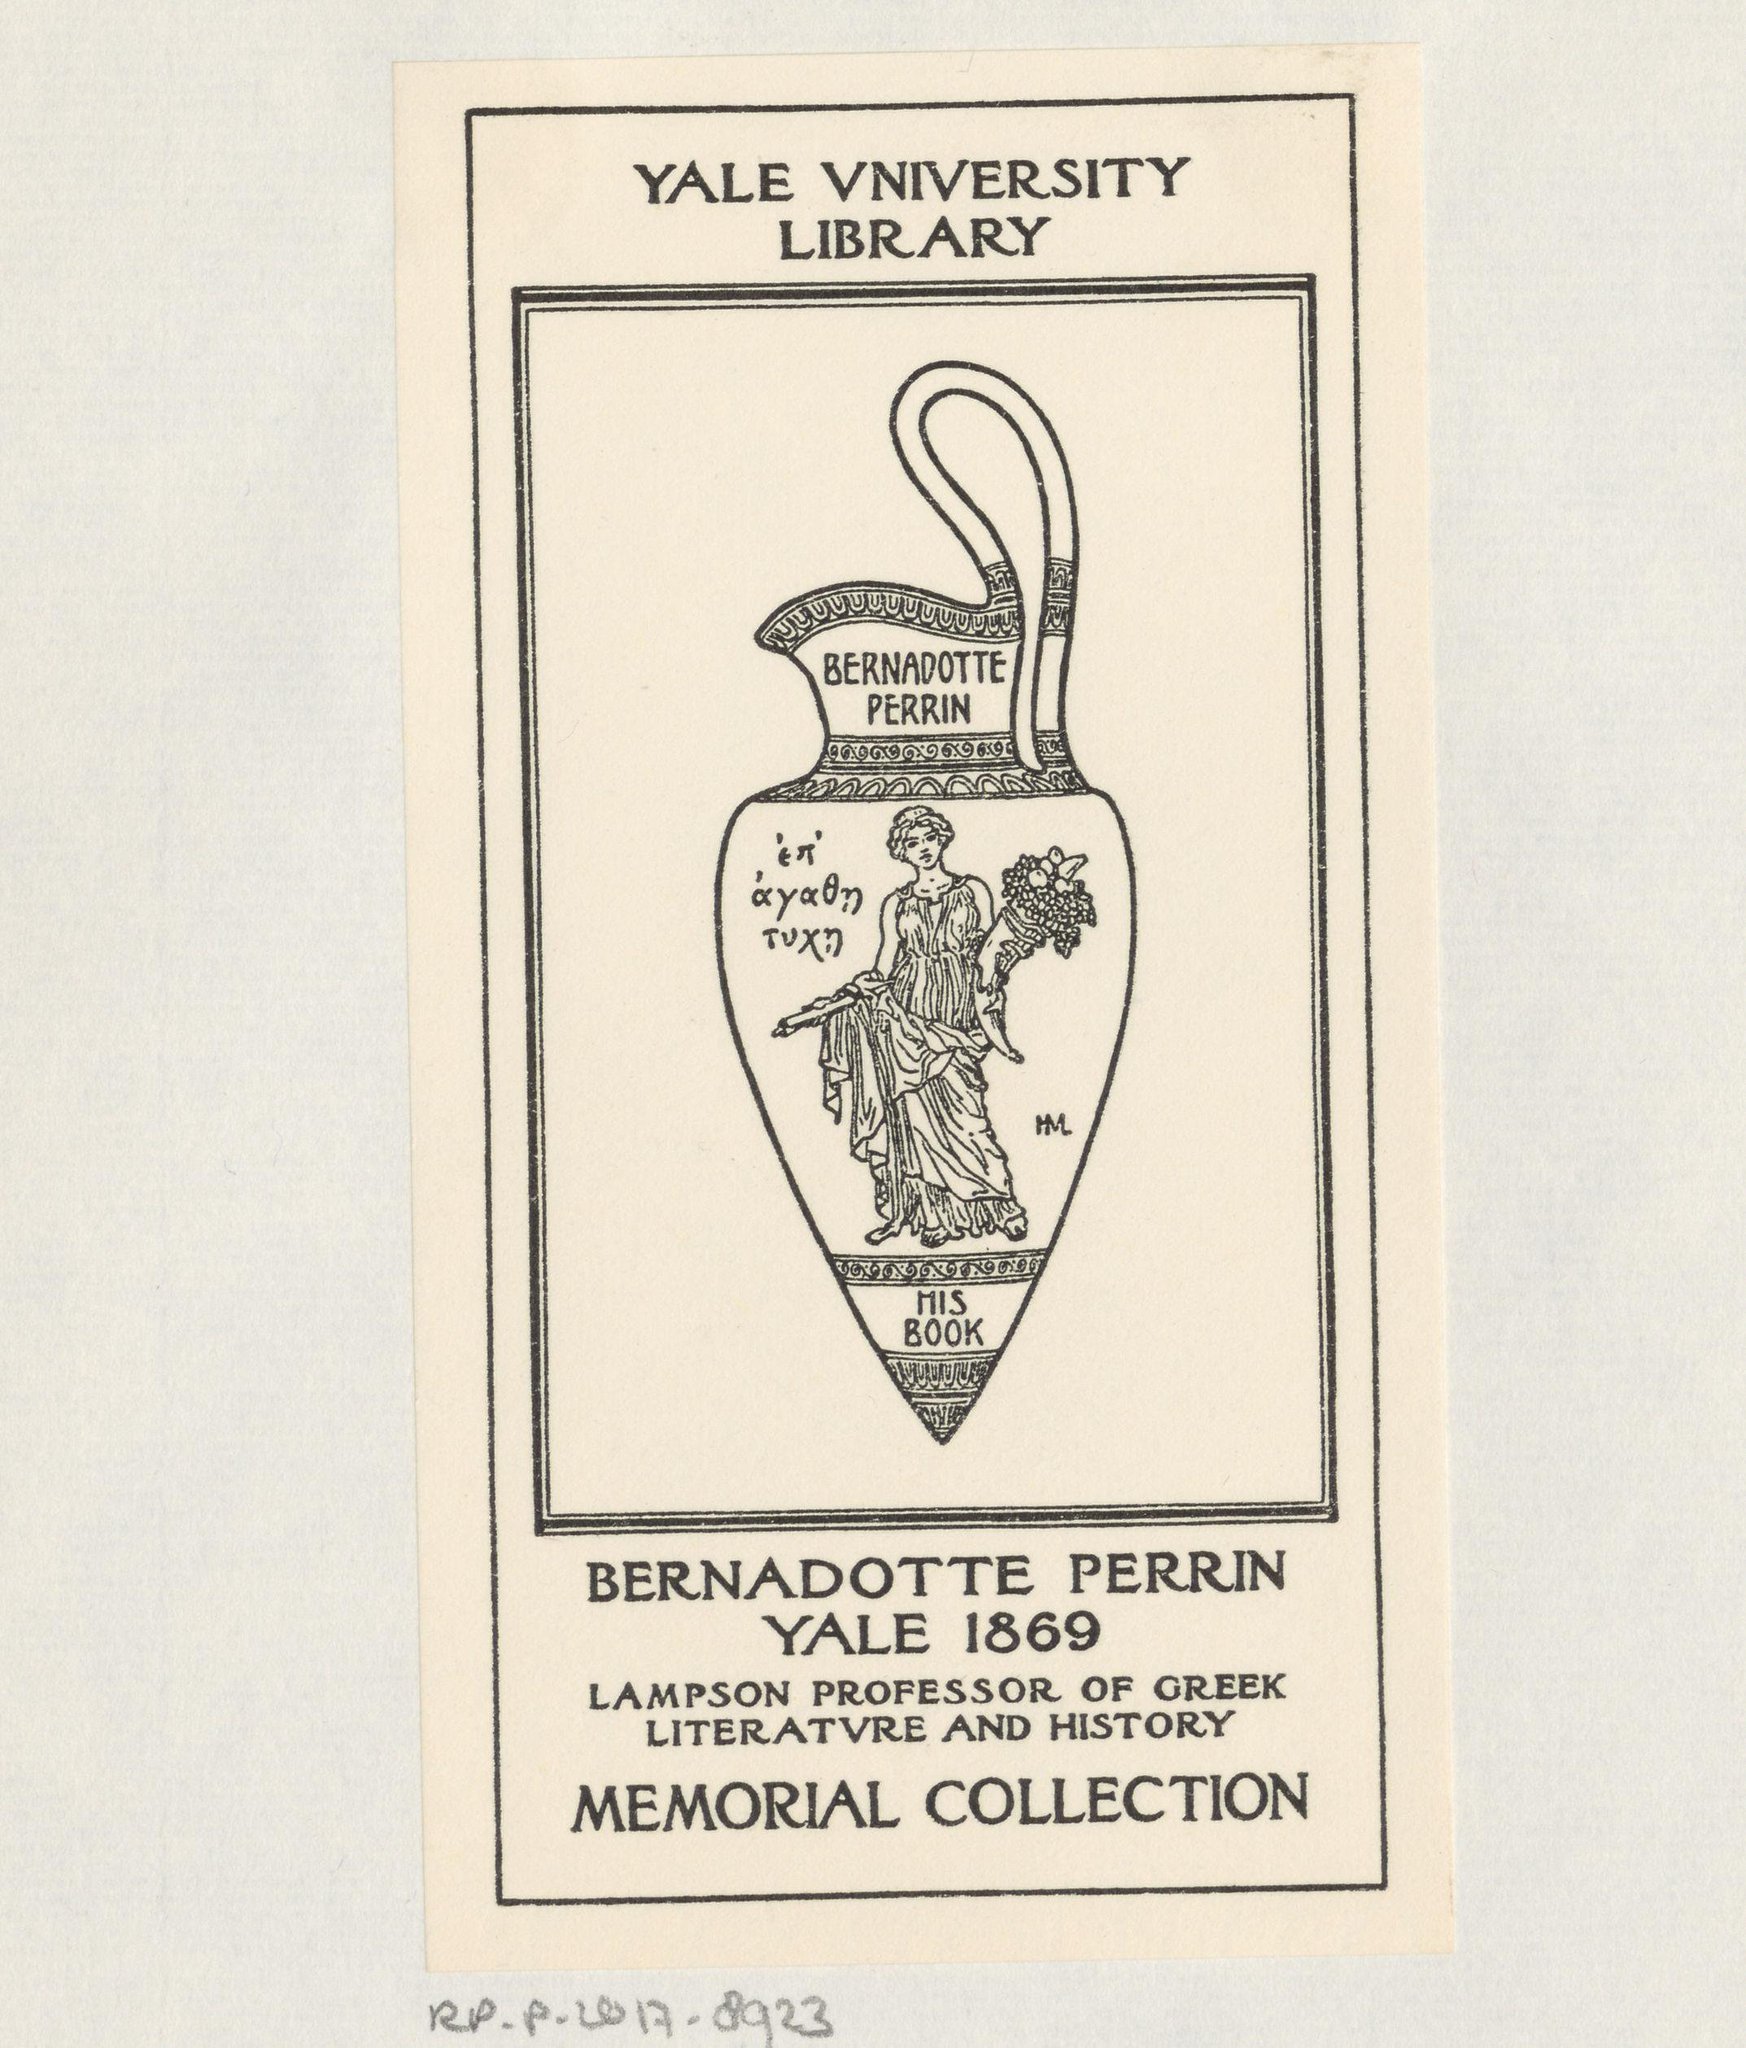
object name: bookplate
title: Ex libris van de Yale University Library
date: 1900-1999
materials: paper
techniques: printing block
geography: north and central america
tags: university, standing figure - aa - female human figure, container of ceramics: jar, jug, pot, vase